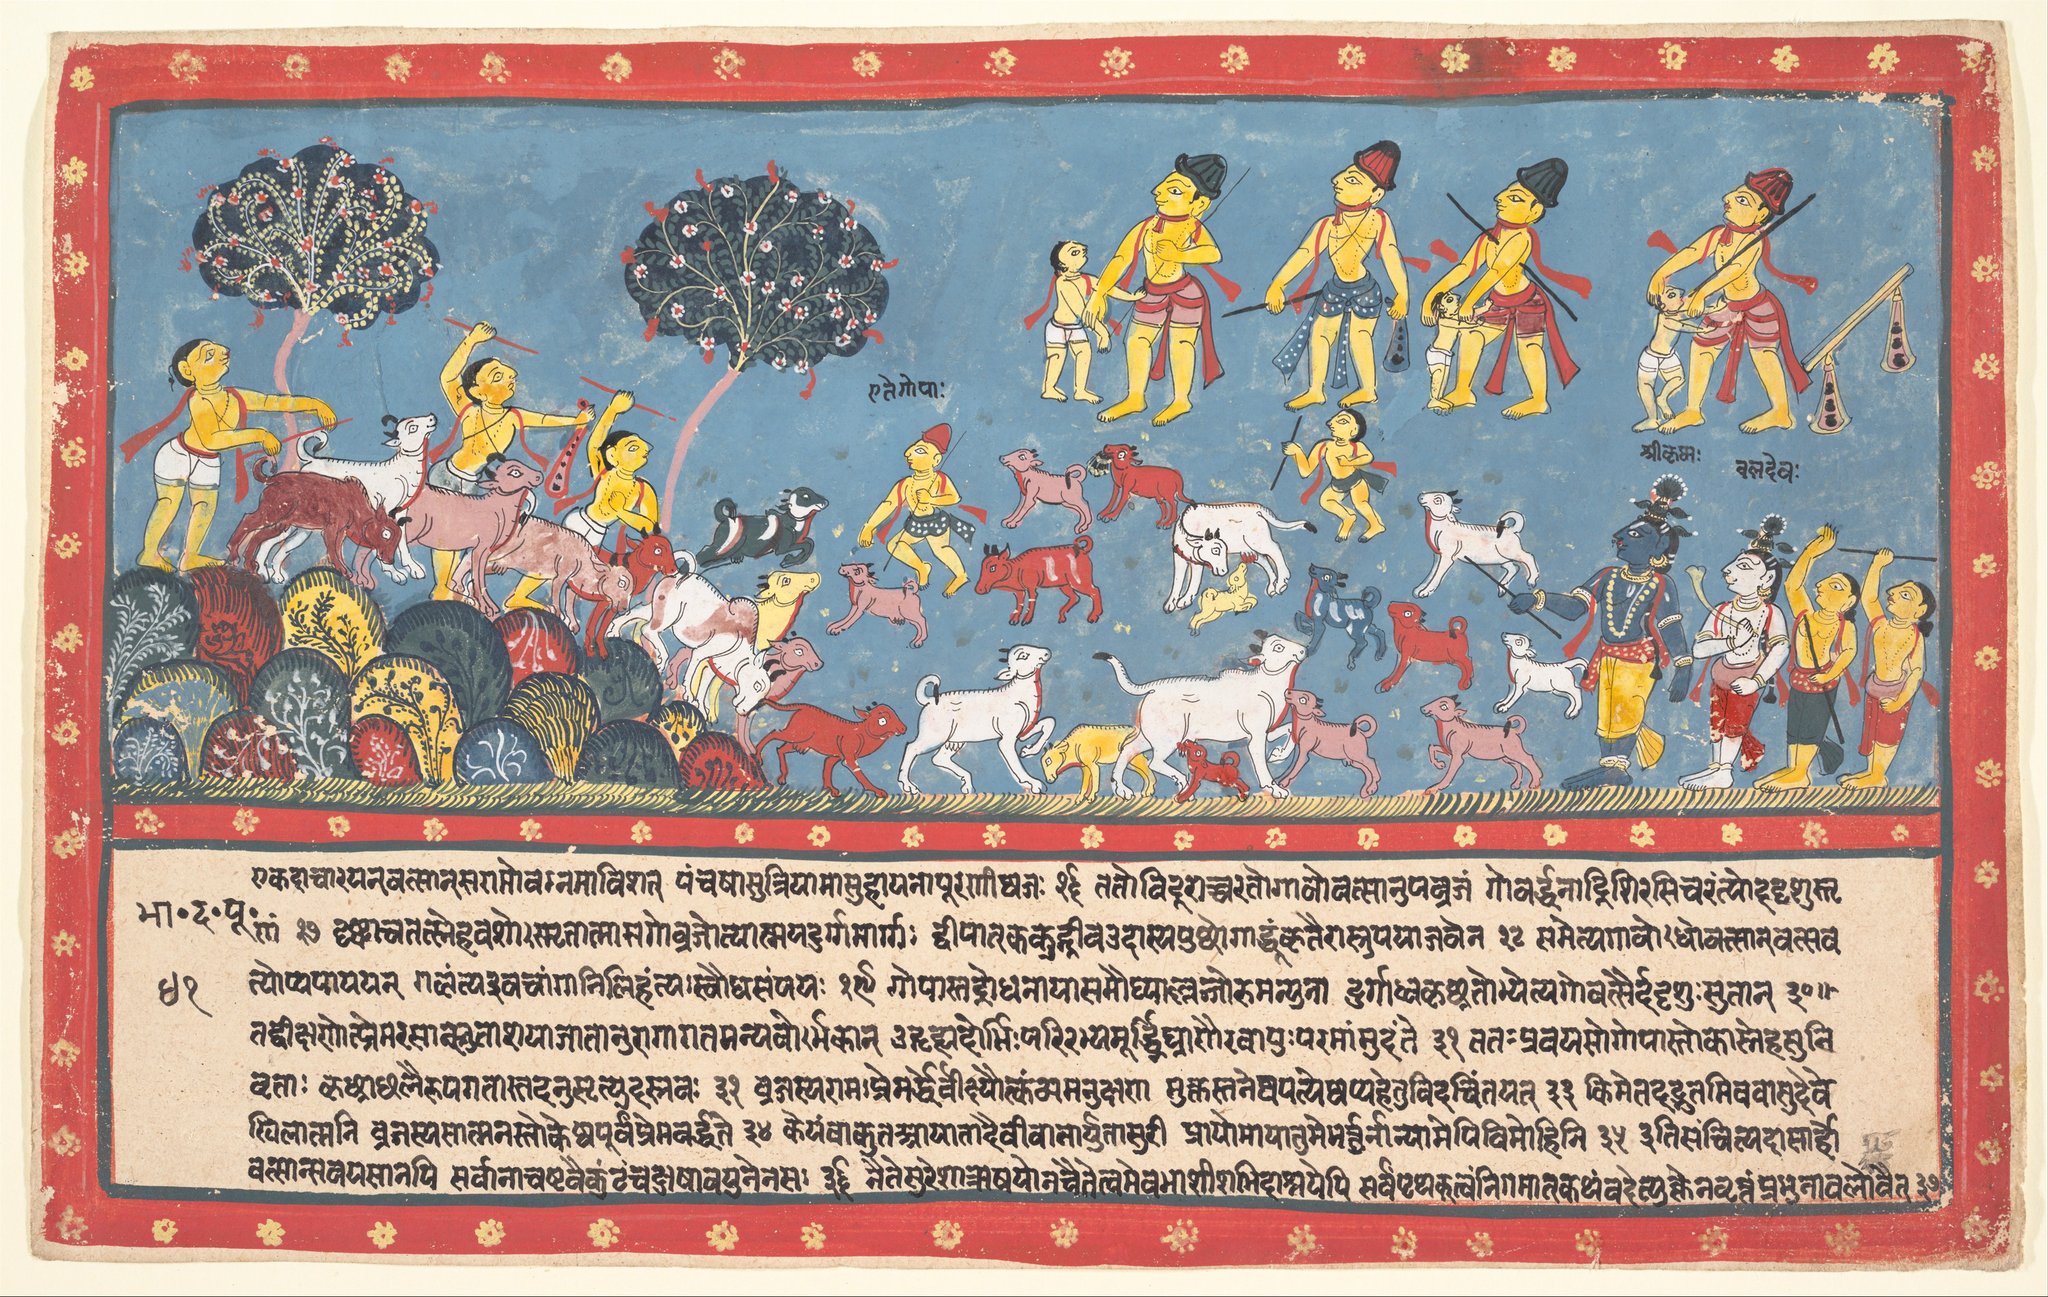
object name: folio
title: Krishna, Balarama, and the Cowherders: Page from a Dispersed Bhagavata Purana (Ancient Stories of Lord Vishnu)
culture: indian, orissan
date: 1800-1825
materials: ink, paper, watercolor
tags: men,cows,krishna